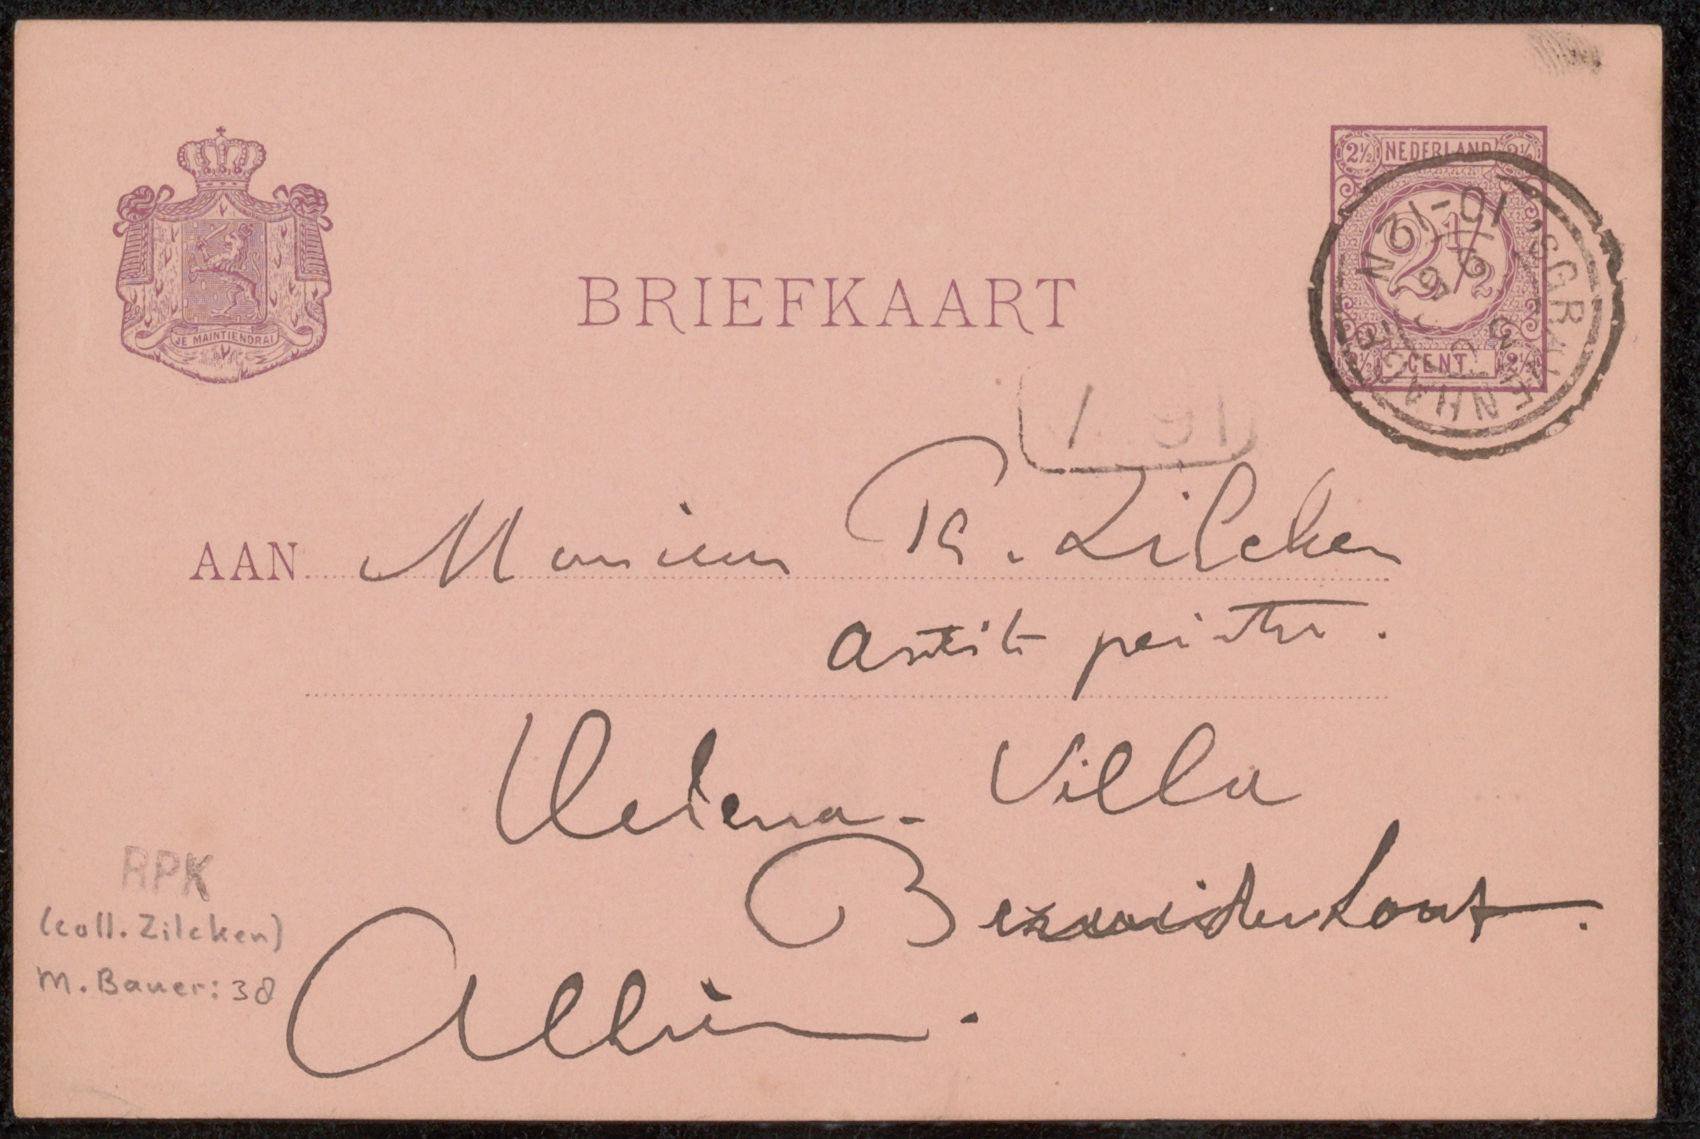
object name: postcard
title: Briefkaart aan Philip Zilcken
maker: marius bauer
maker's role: draughtsman, print maker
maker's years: 1867-1932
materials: cardboard, ink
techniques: pen, writing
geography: the hague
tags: painter, draughtsman, philip zilcken, venice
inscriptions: collector's mark: ‘RPK’